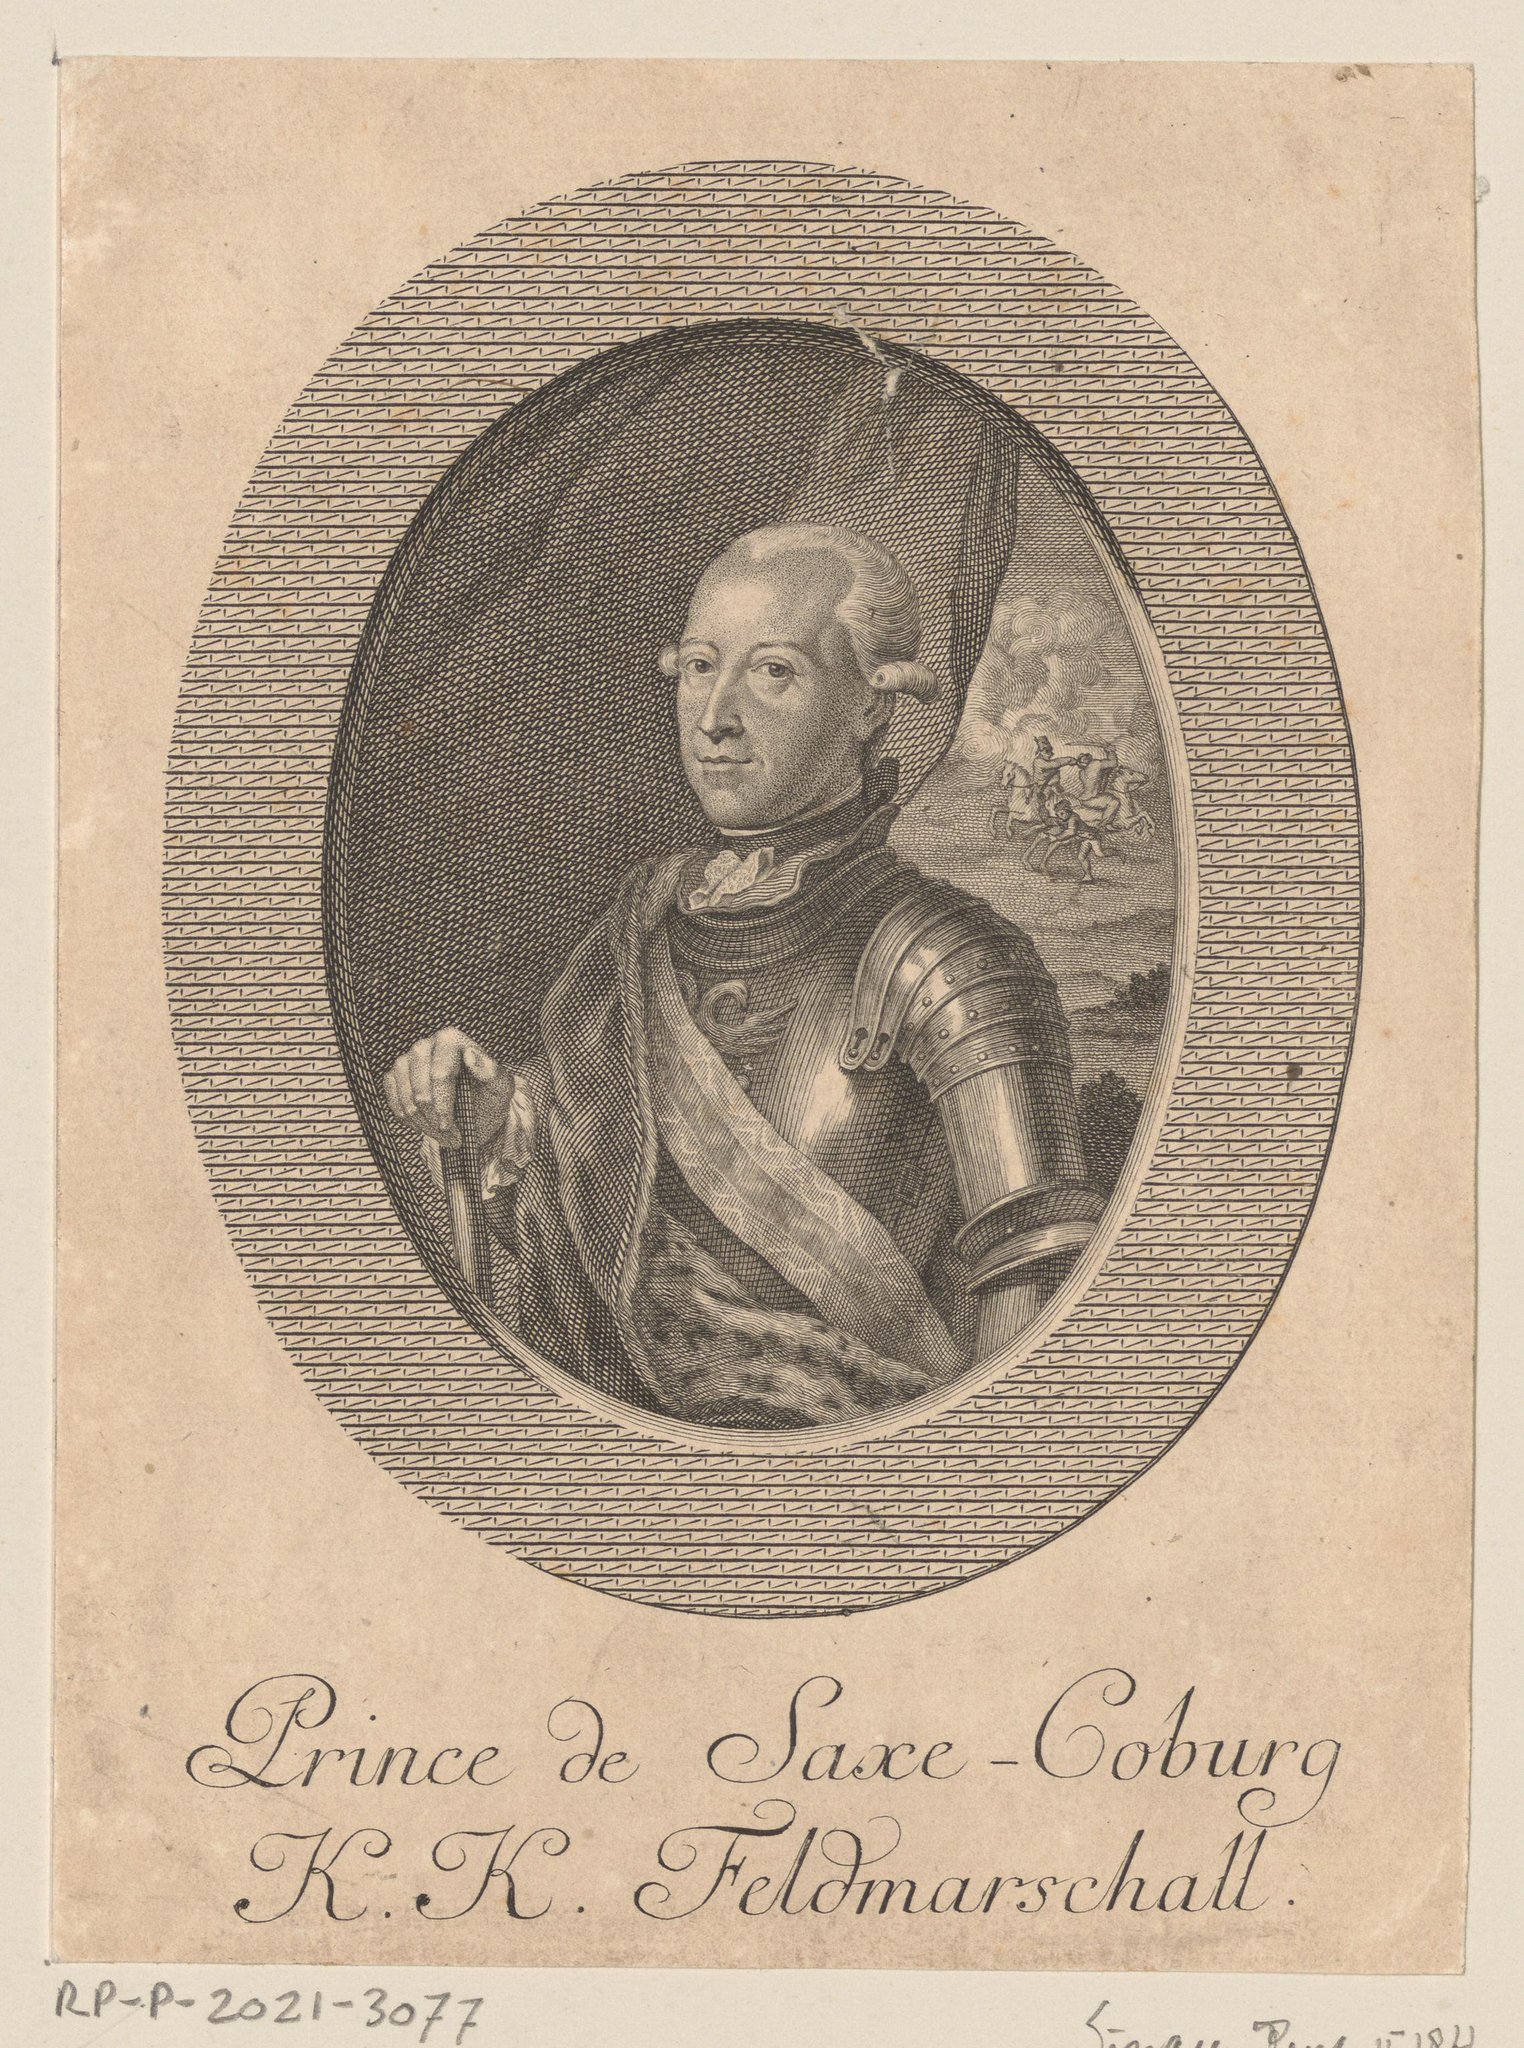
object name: print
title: Portret van Frederik Jozias Saksen-Coburg-Saalfeld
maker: Anonymous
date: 1789-1837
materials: paper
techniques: engraving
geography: augsburg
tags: commander-in-chief, general, marshal, prince, historical persons